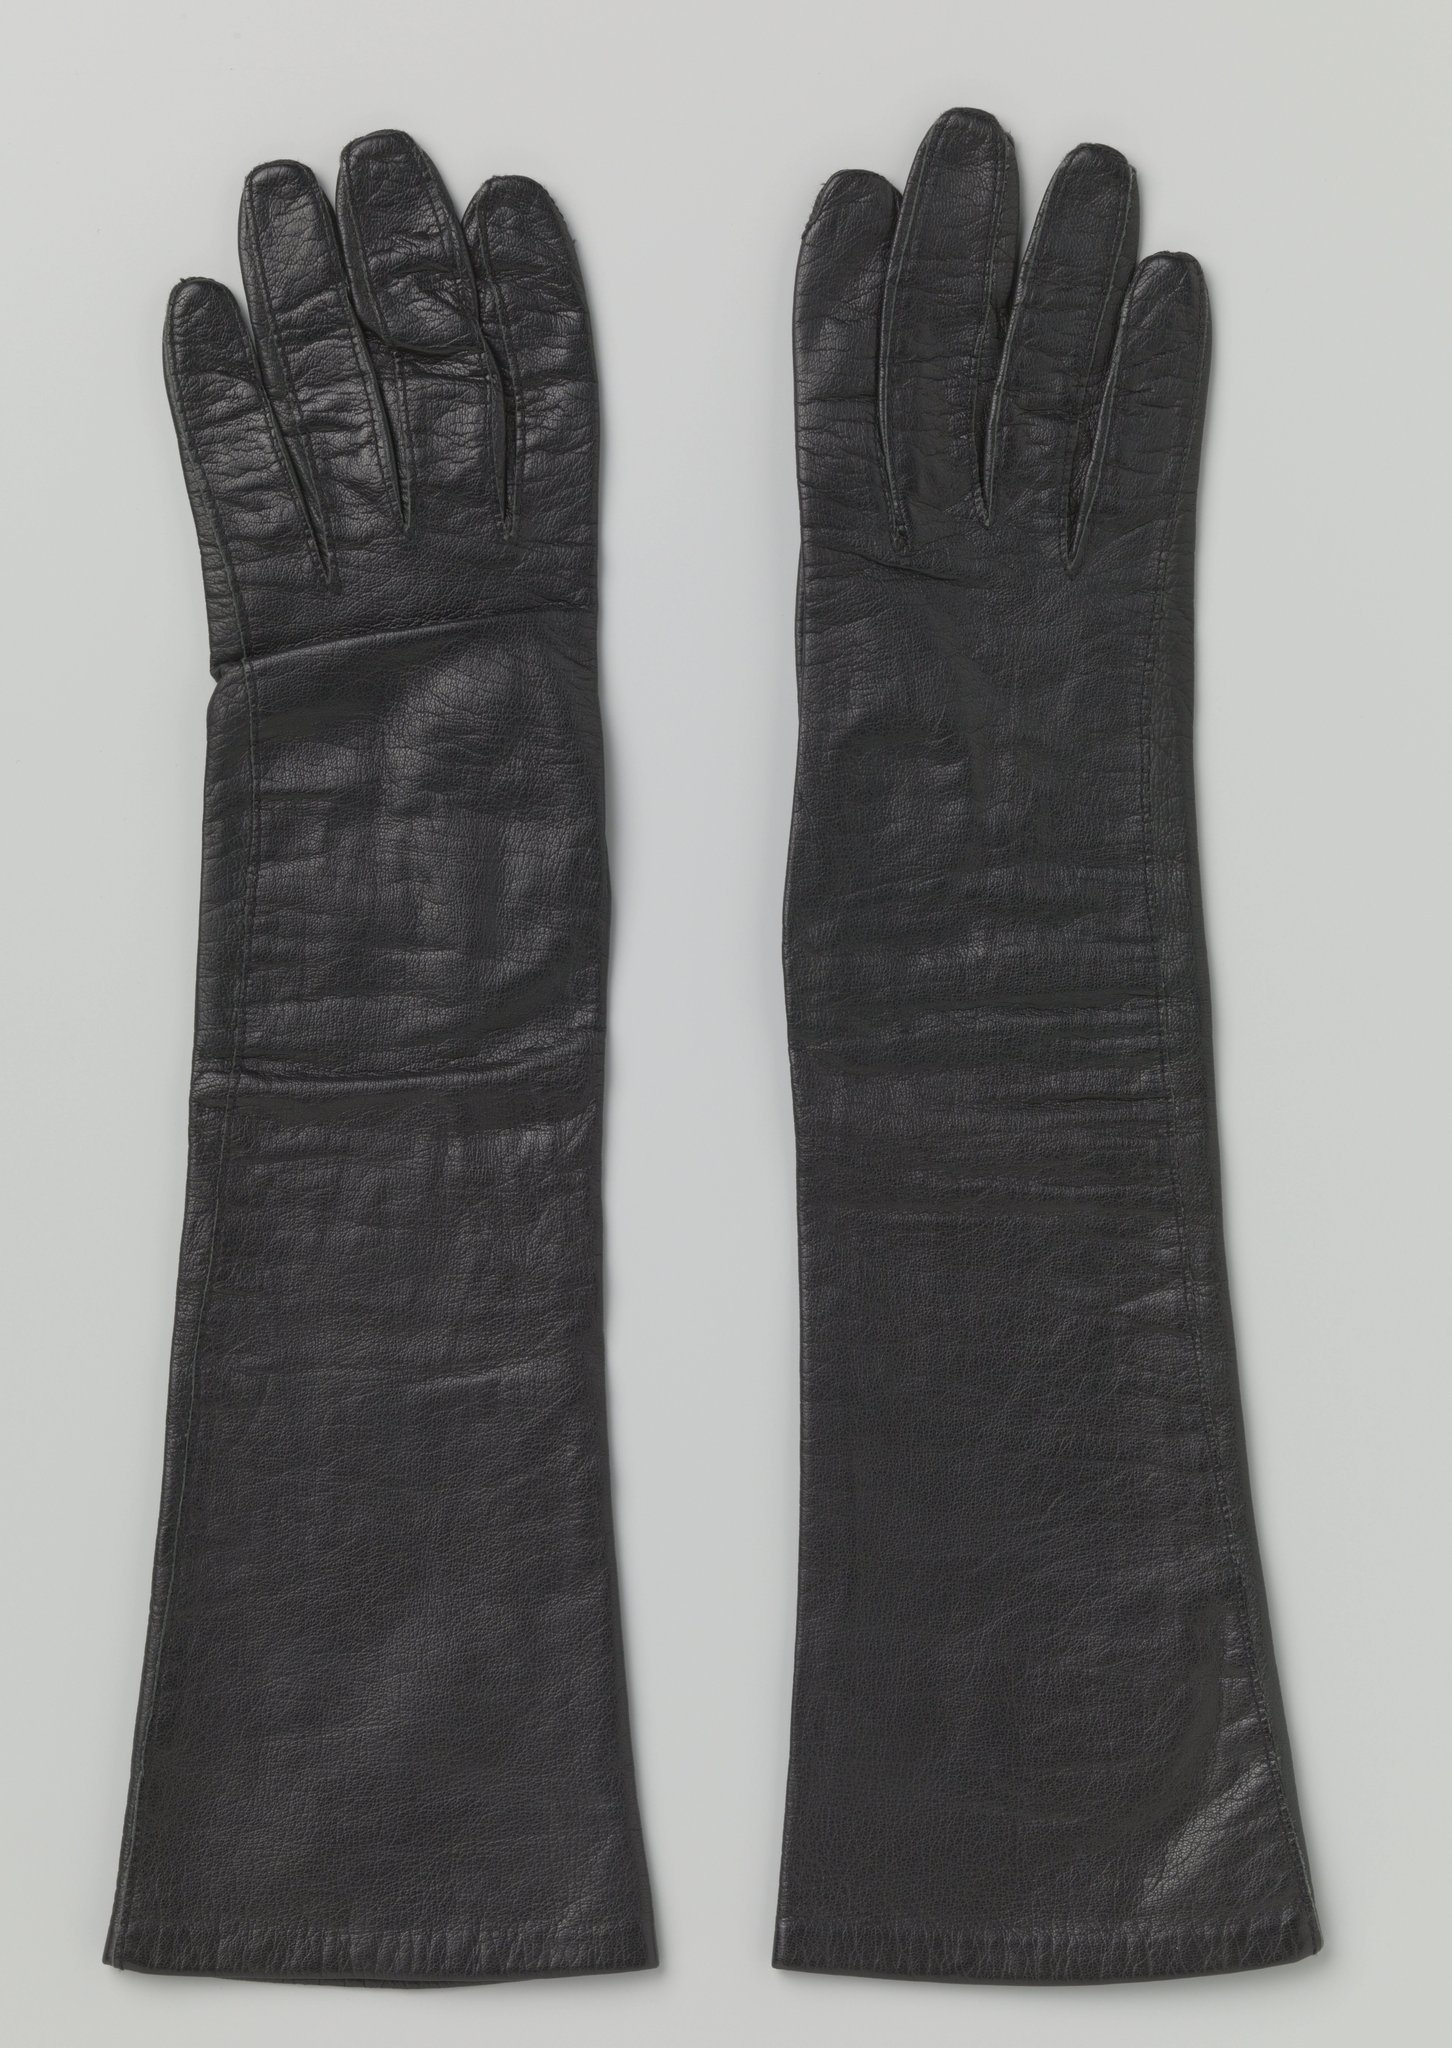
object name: glove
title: Handschoen van zwart leer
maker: Anonymous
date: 1900-1915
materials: leather, silk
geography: france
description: Linker handschoen van zwart glaceleer gevoerd met grijze zijde.